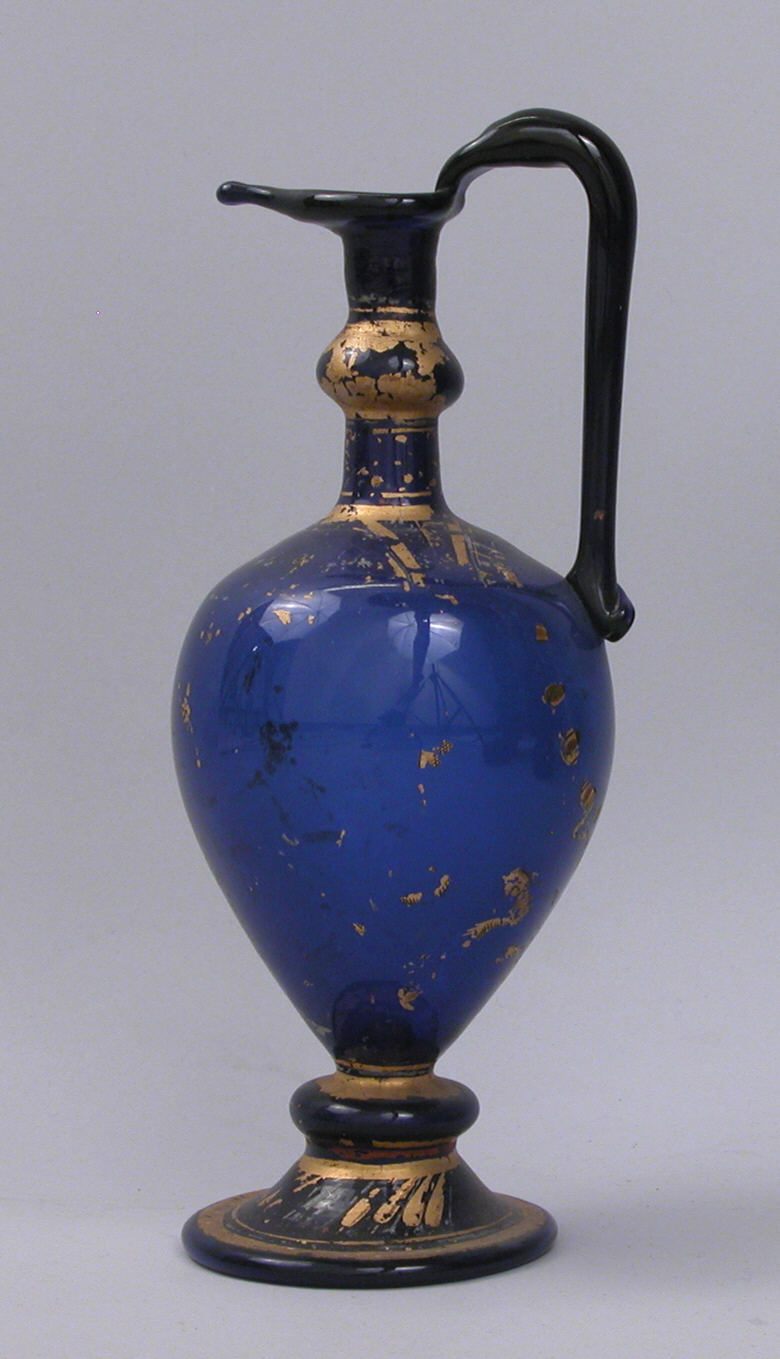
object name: ewer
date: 1701-1900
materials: glass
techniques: glassblowing, painting, tooling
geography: iran